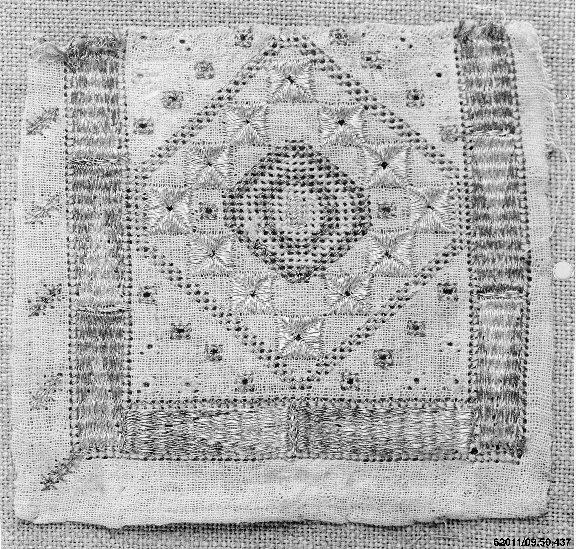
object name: square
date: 1701-1900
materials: linen, metal thread, silk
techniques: embroidery, weave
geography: syria